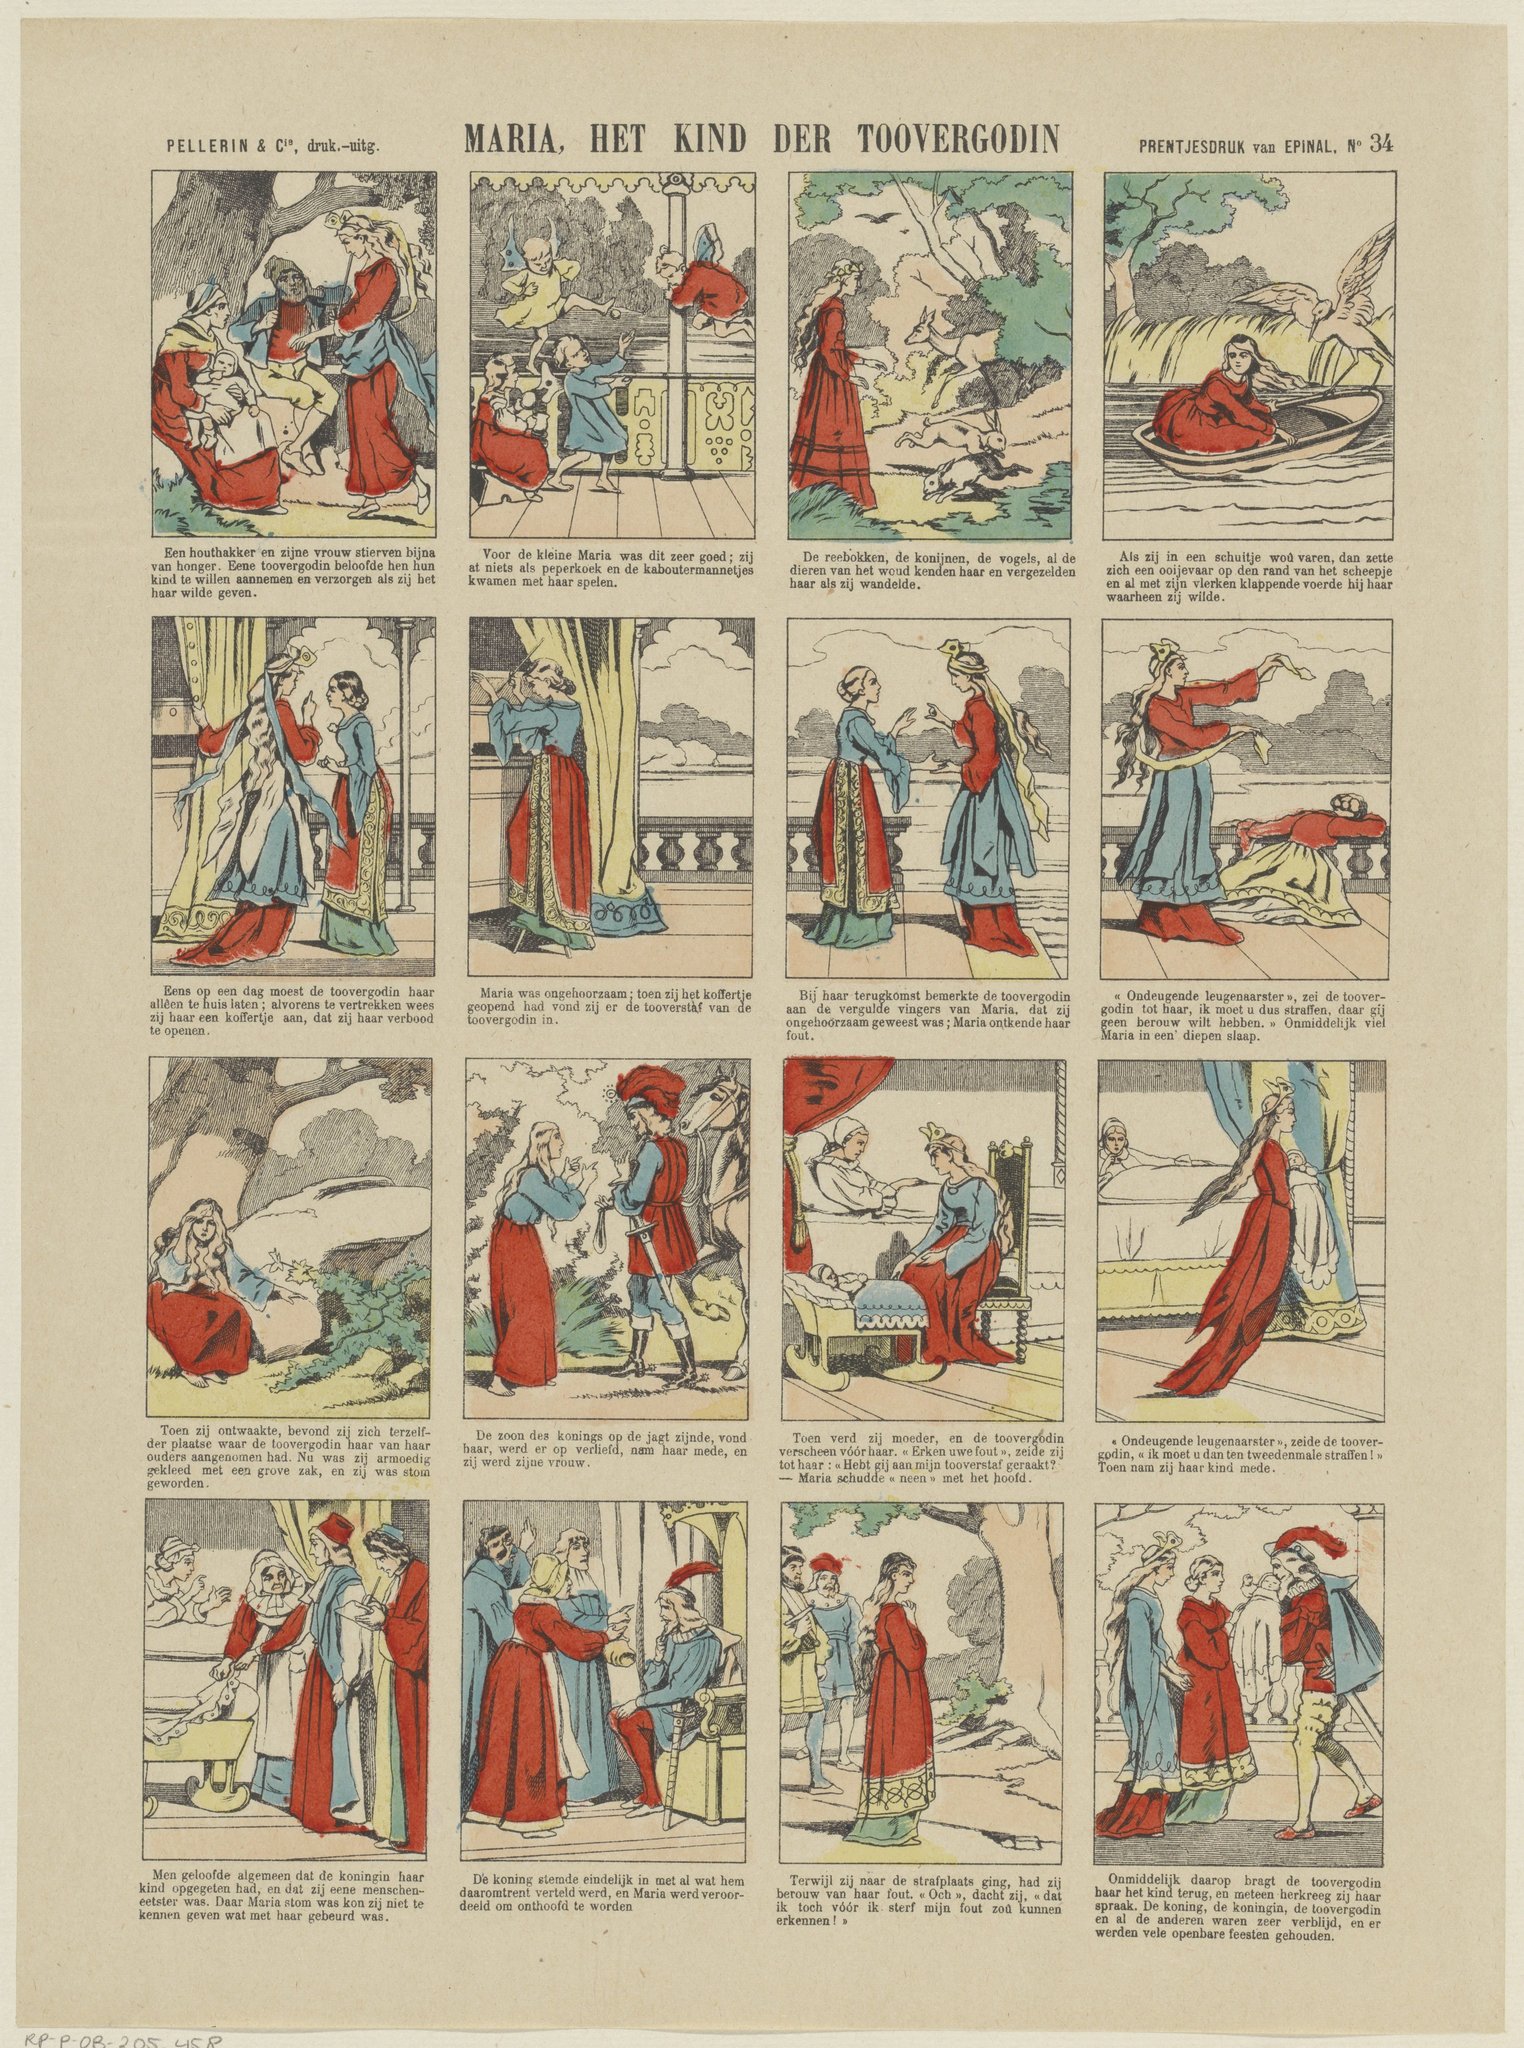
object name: popular print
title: Prentjesdruk van Épinal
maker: Anonymous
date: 1902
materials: paper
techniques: colour, letterpress printing, lithograph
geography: epinal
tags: prince, fairy, tales and fairy tales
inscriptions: collector's mark: Lugt 2760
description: Blad met 16 voorstellingen uit het verhaal van Maria, de dochter van de tovergodin. Onder elke afbeelding een onderschrift. Genummerd rechtsboven: No 34.